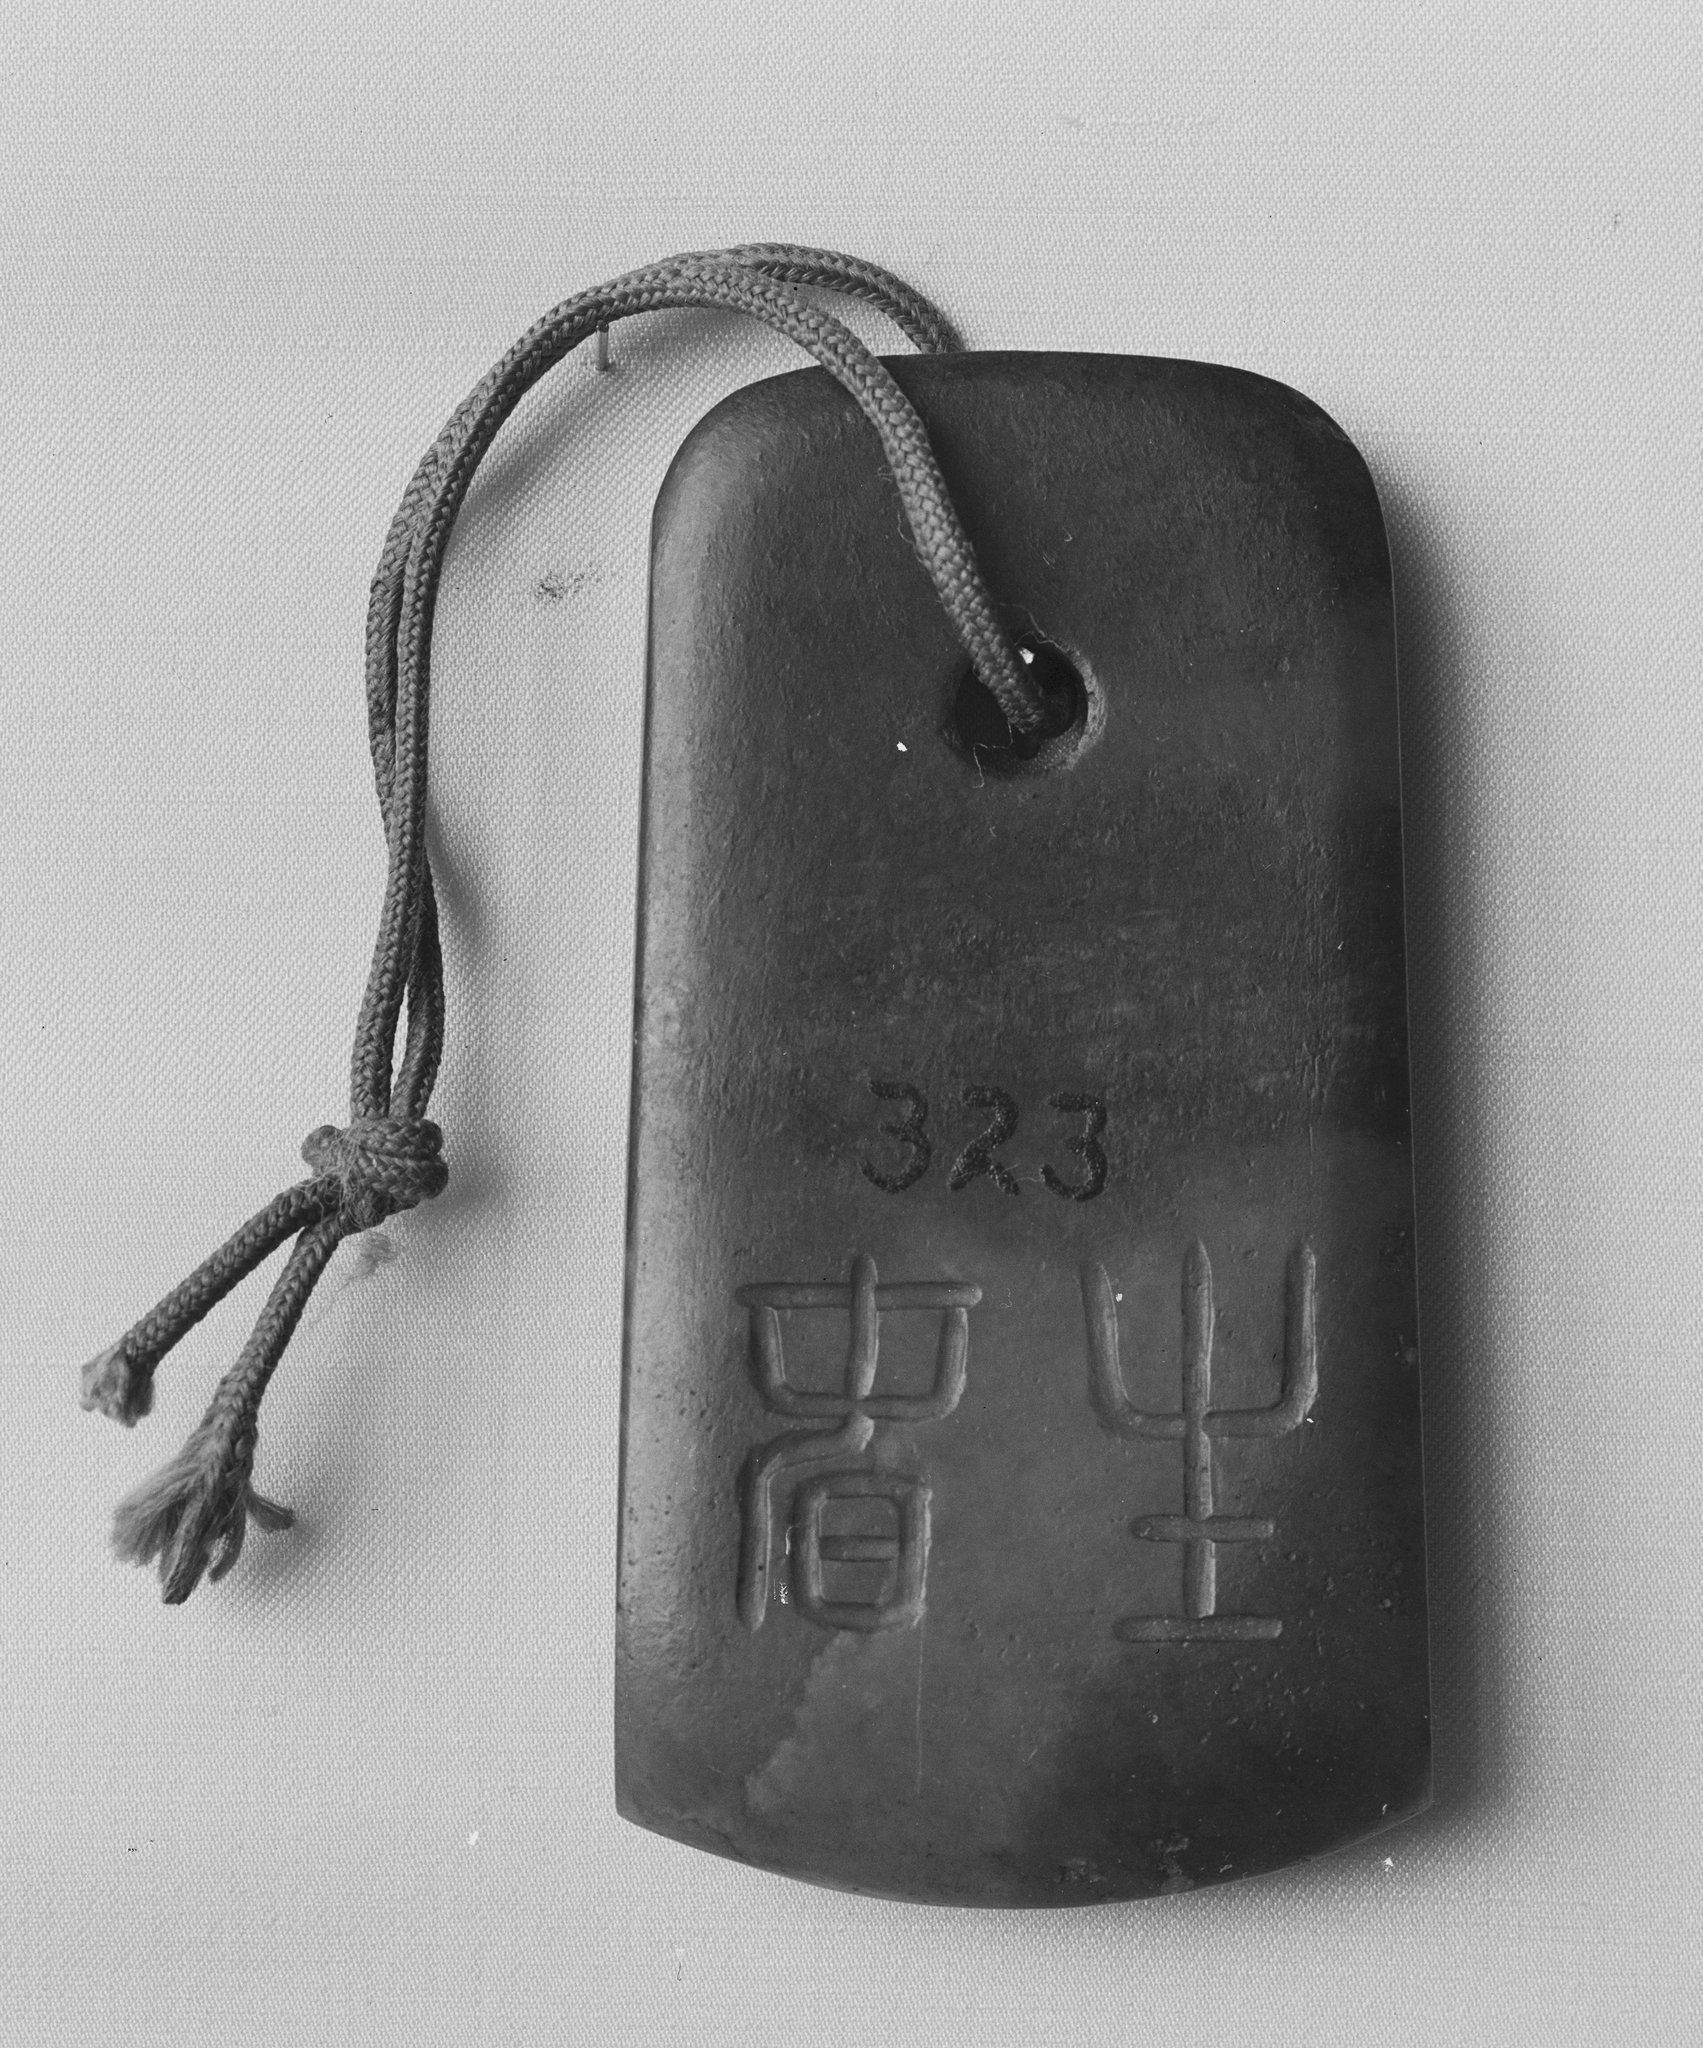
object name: celt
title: Ax Blade (Celt)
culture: chinese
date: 206 BCE-220 CE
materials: jade